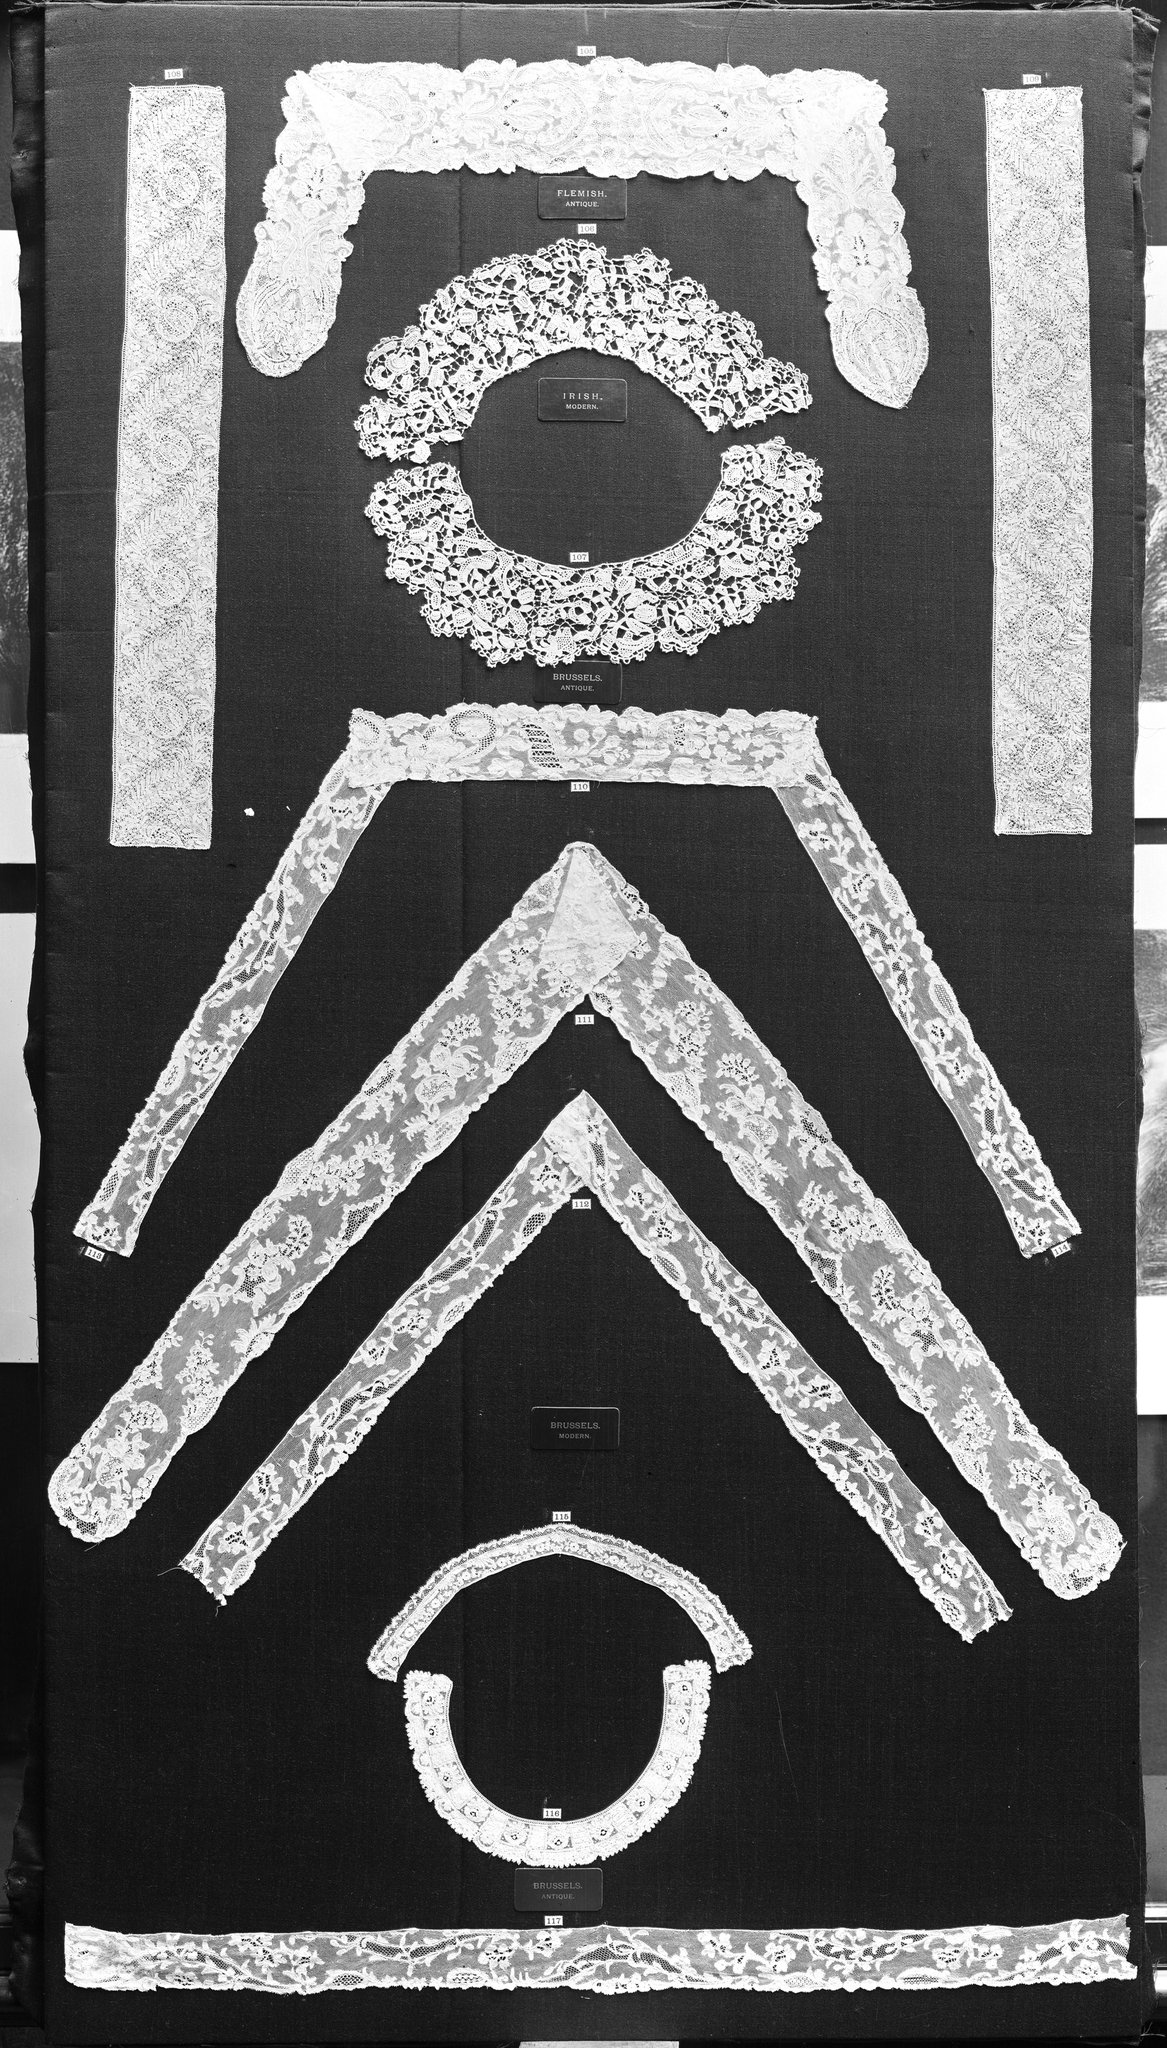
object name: fragment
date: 1701-1800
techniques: lace